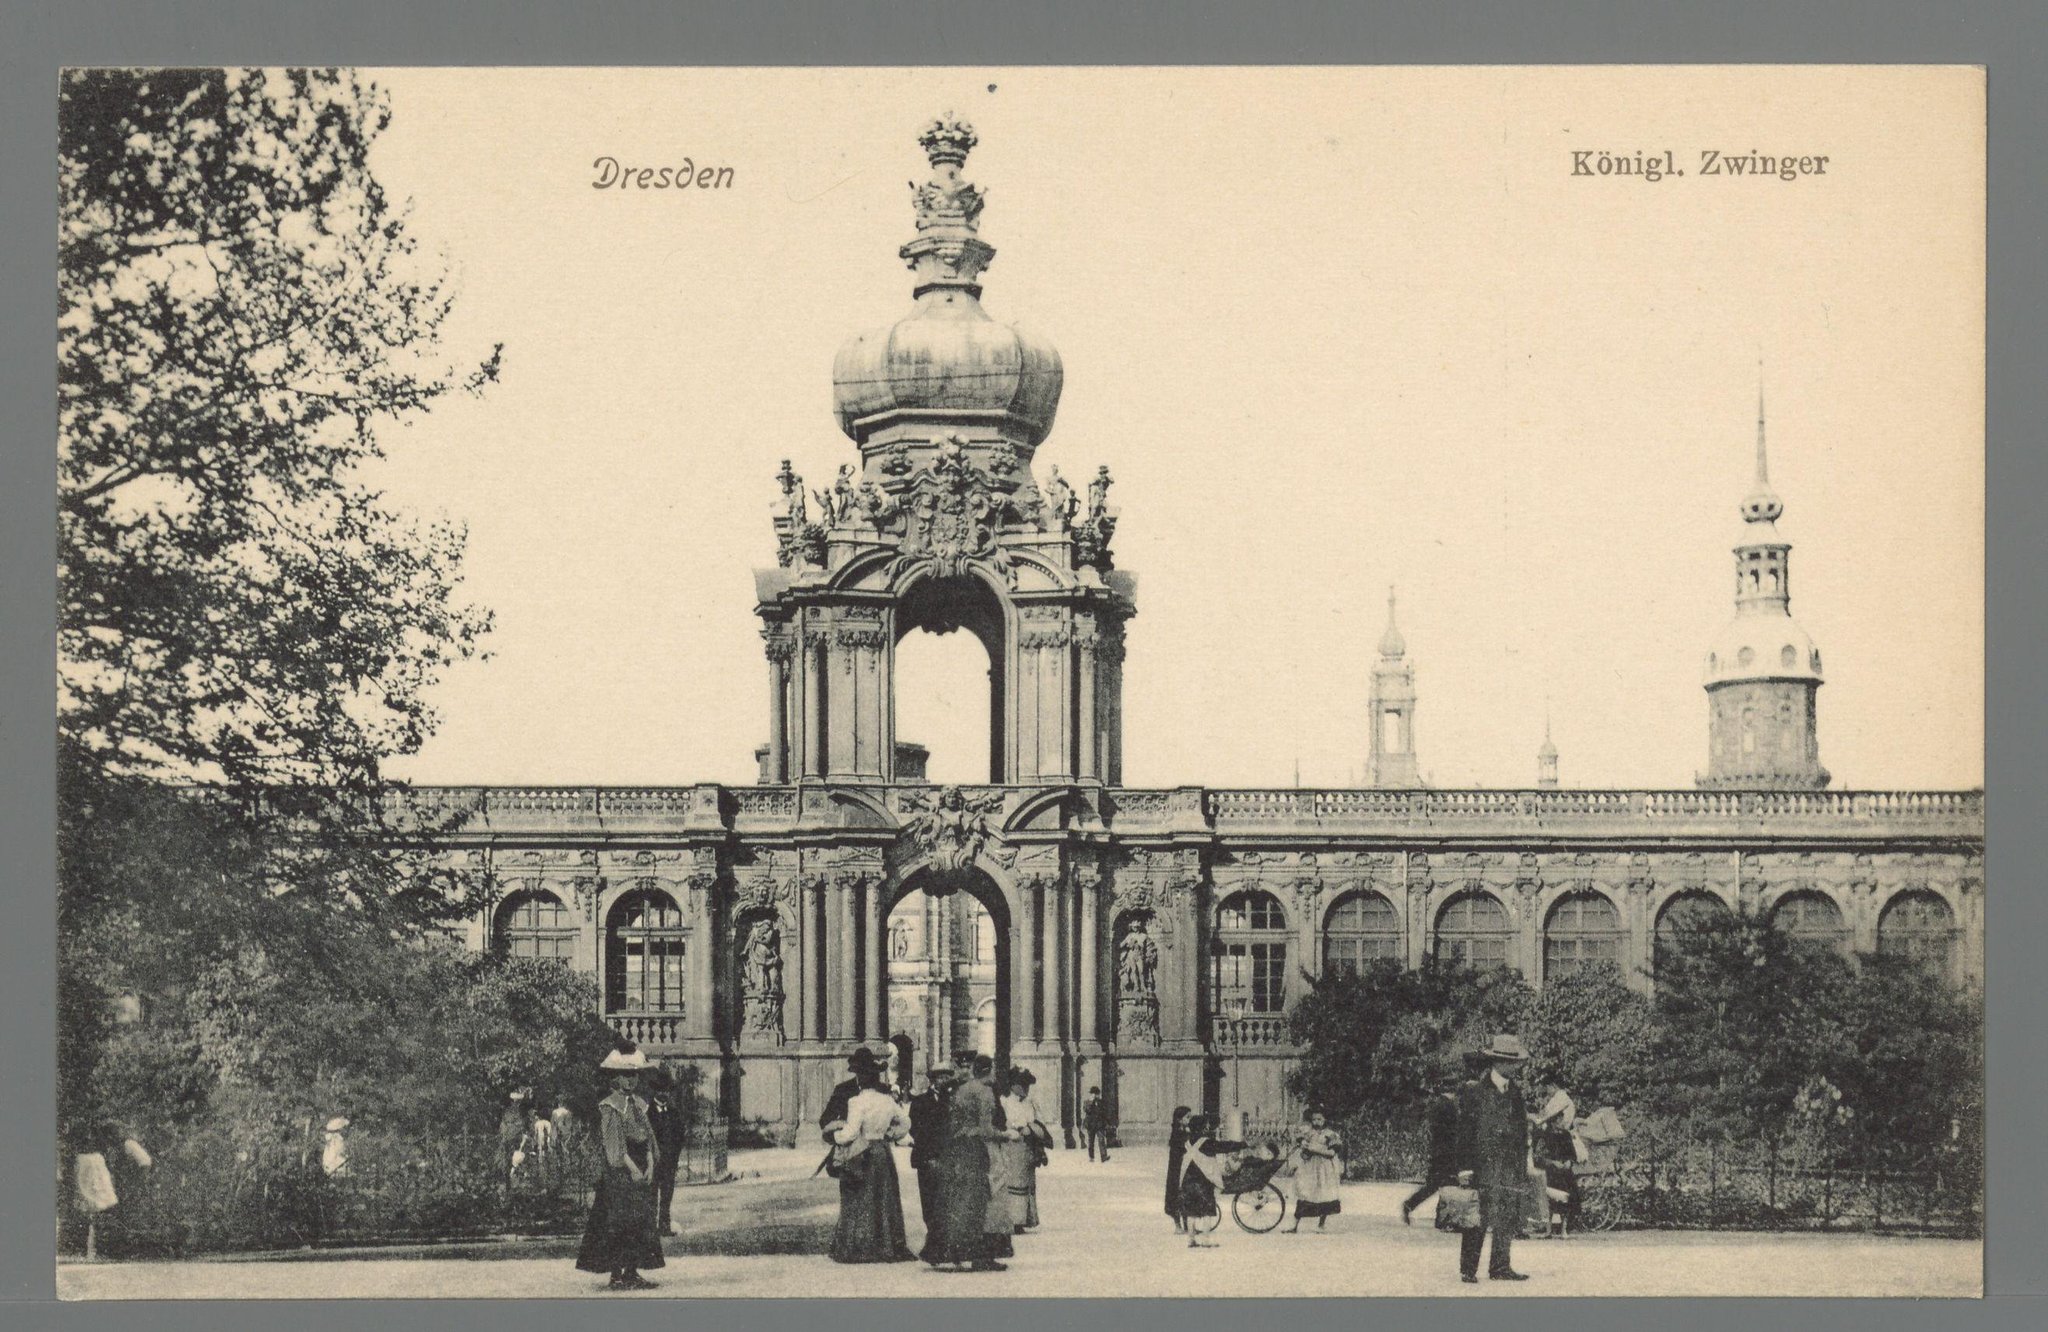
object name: ansichtkaart, prentbriefkaart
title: Dresden. Königl. Zwinger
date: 1905-1930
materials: cardboard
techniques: photograph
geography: dresden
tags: palace